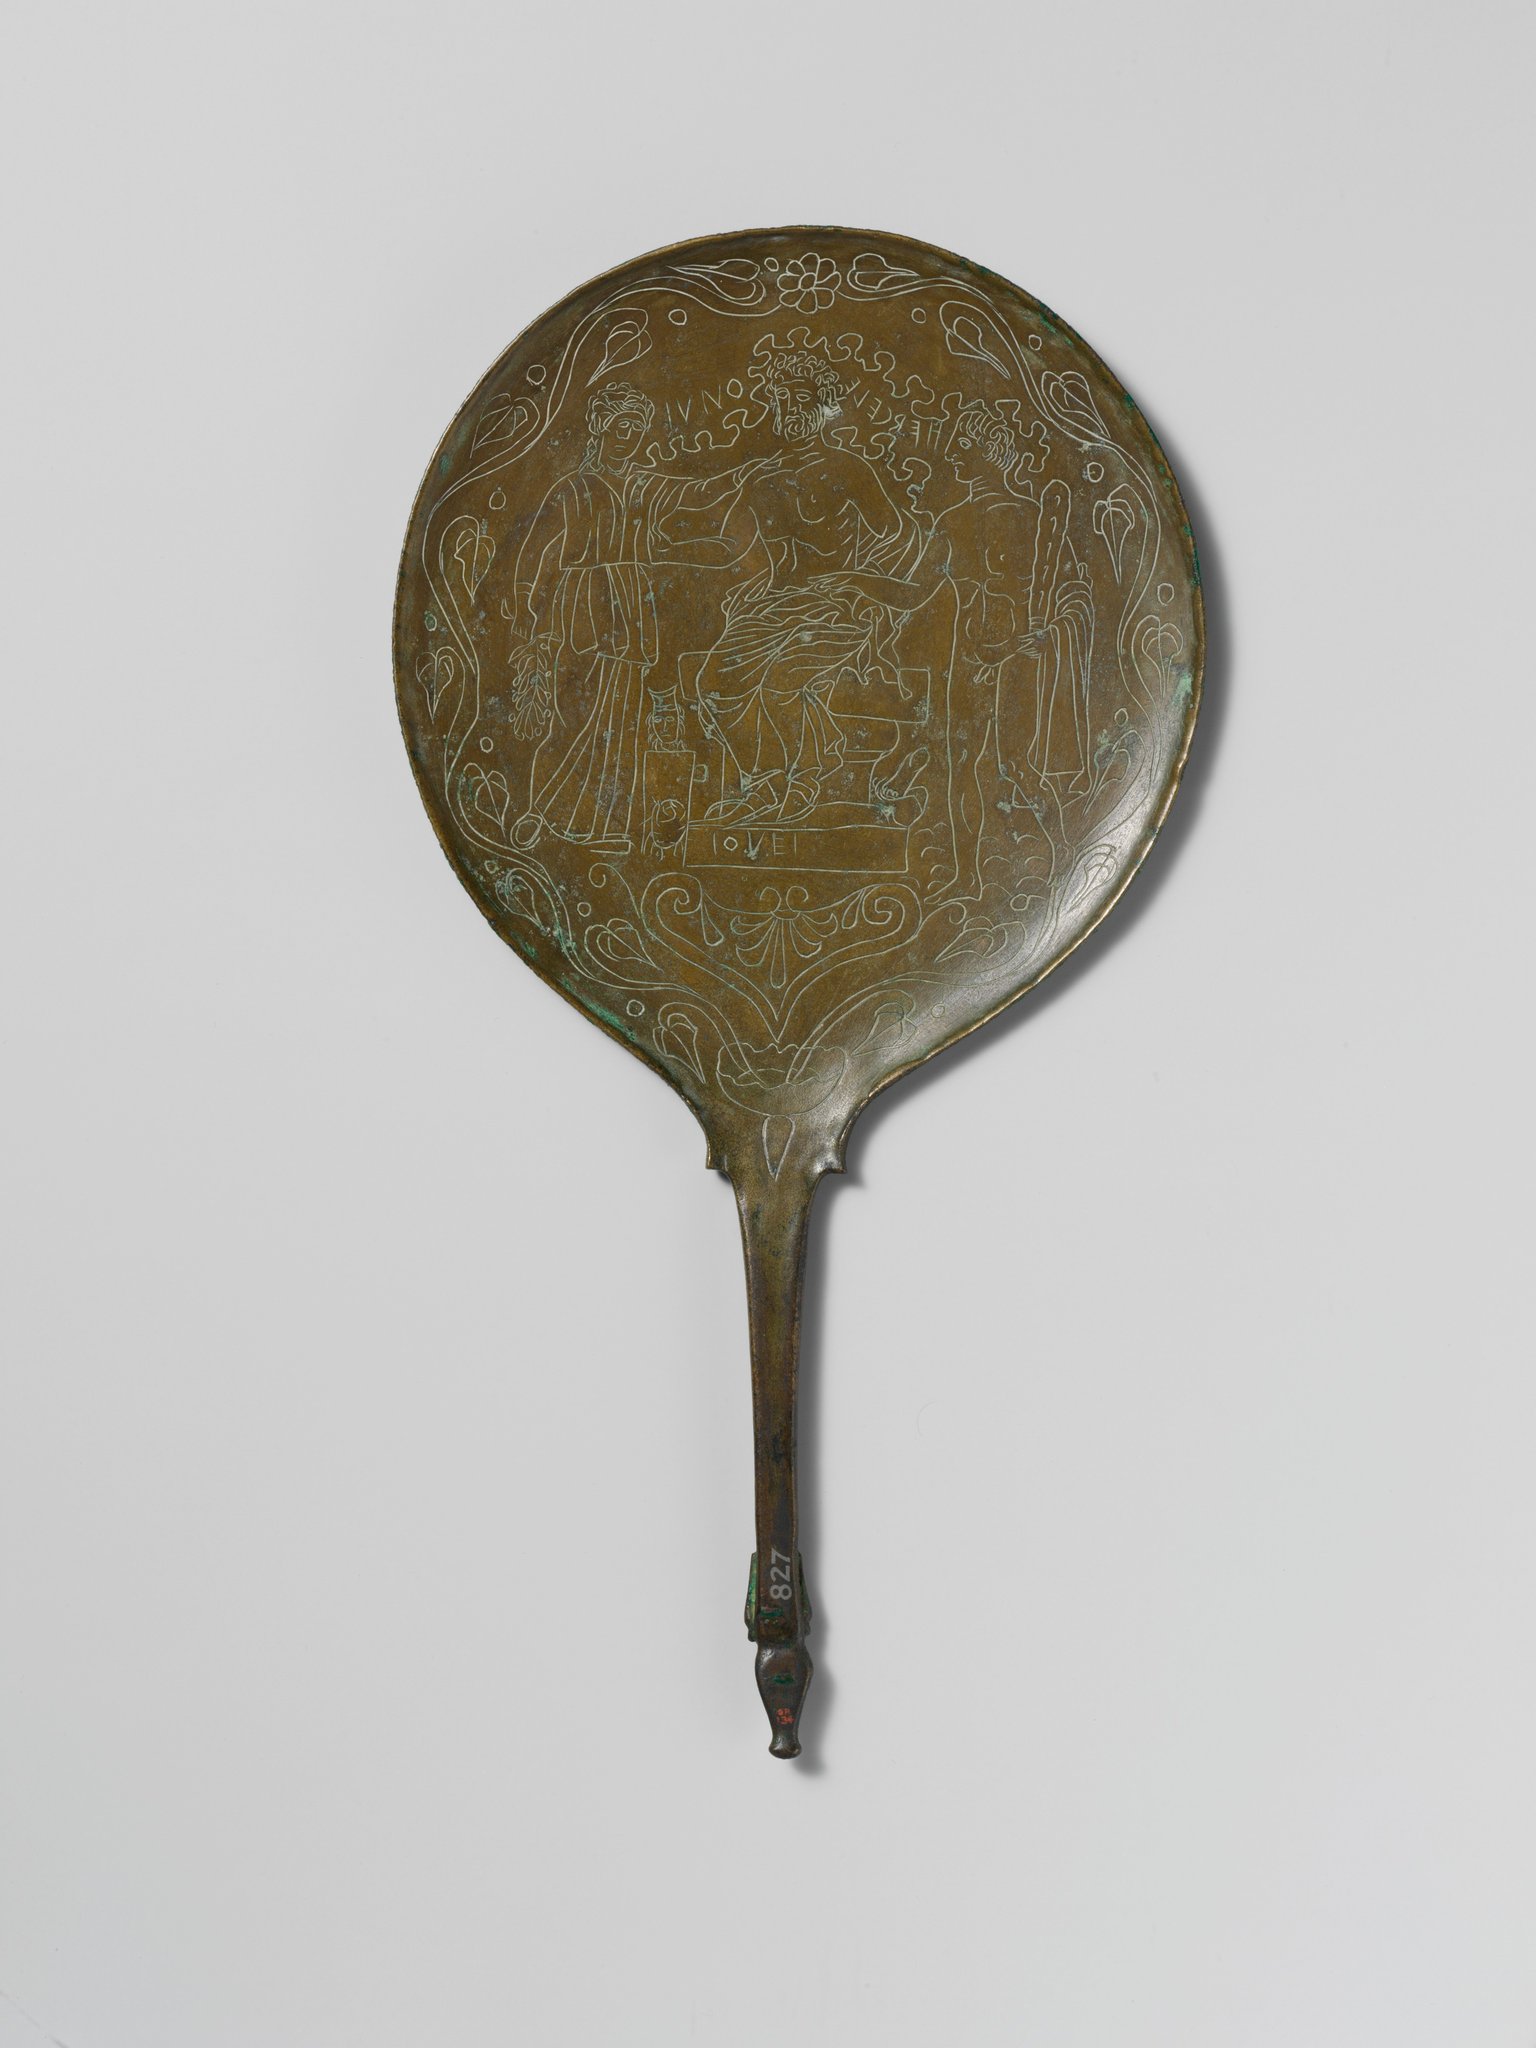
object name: mirror with juno, jupiter, and hercules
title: Bronze mirror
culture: praenestine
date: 334-268 BCE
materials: bronze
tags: hercules,juno,jupiter